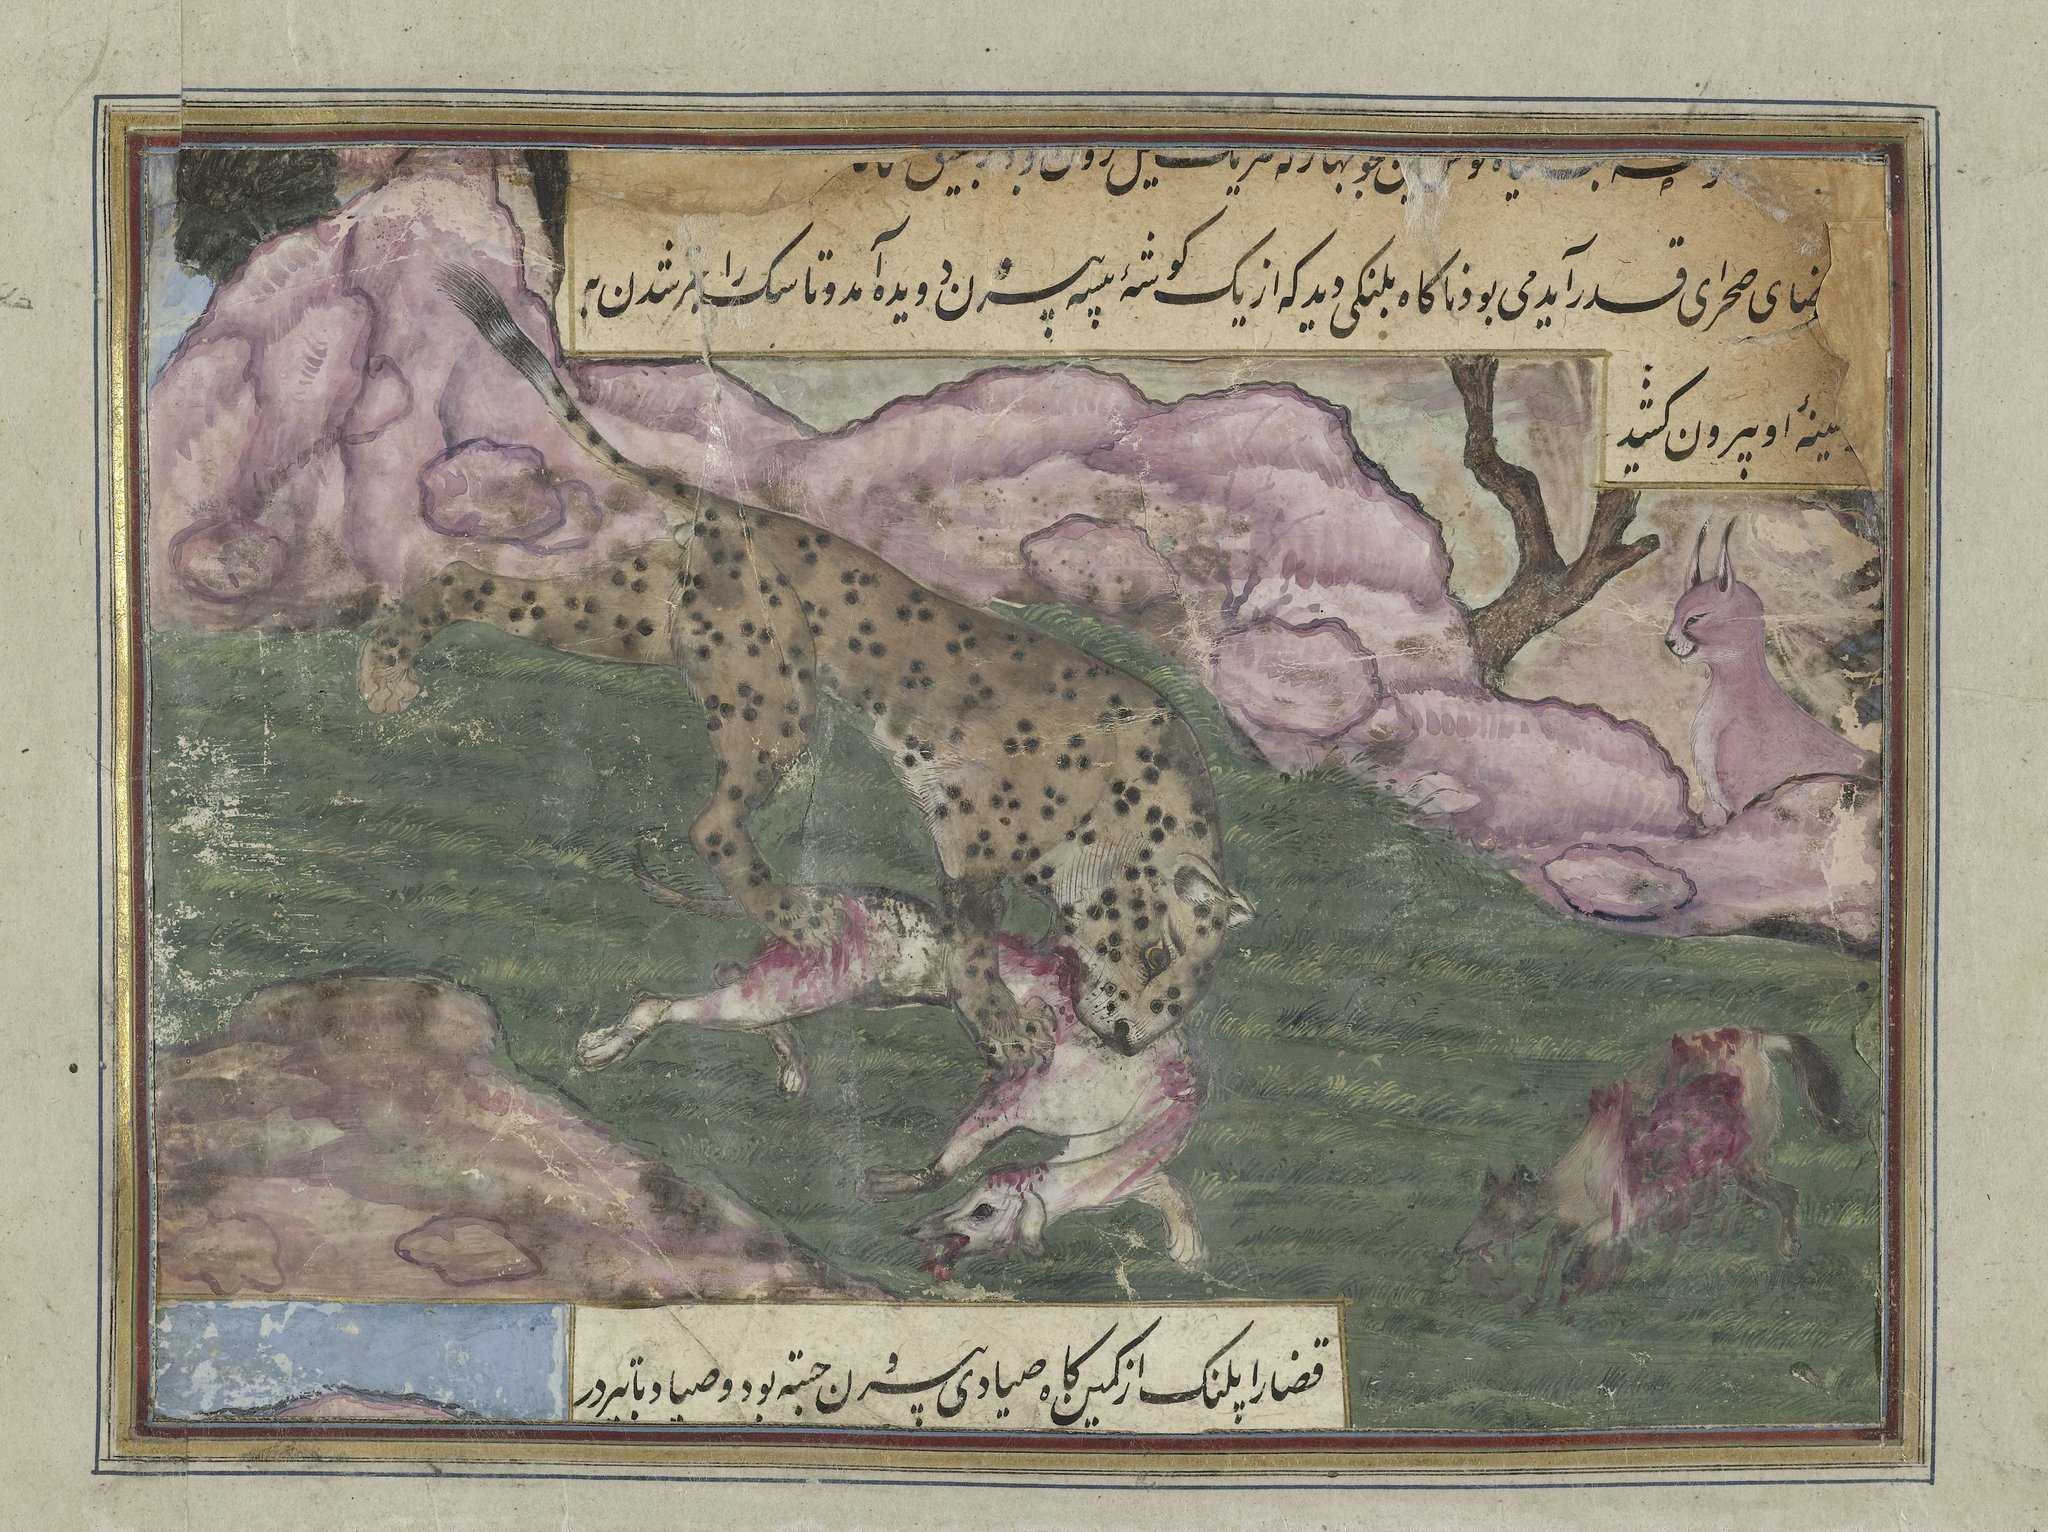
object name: indian miniature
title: Luipaard doodt een hond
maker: Anonymous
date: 1575-1585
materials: paper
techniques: brush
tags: dog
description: Een luipaard heeft een hond die aan de rivier zijn dorst leste een dodelijke beet toegediend; boven en onderaan de voorstelling een rand met tekst. Rond de voorstelling een rode en een gouden bies met zwarte kaderlijnen.